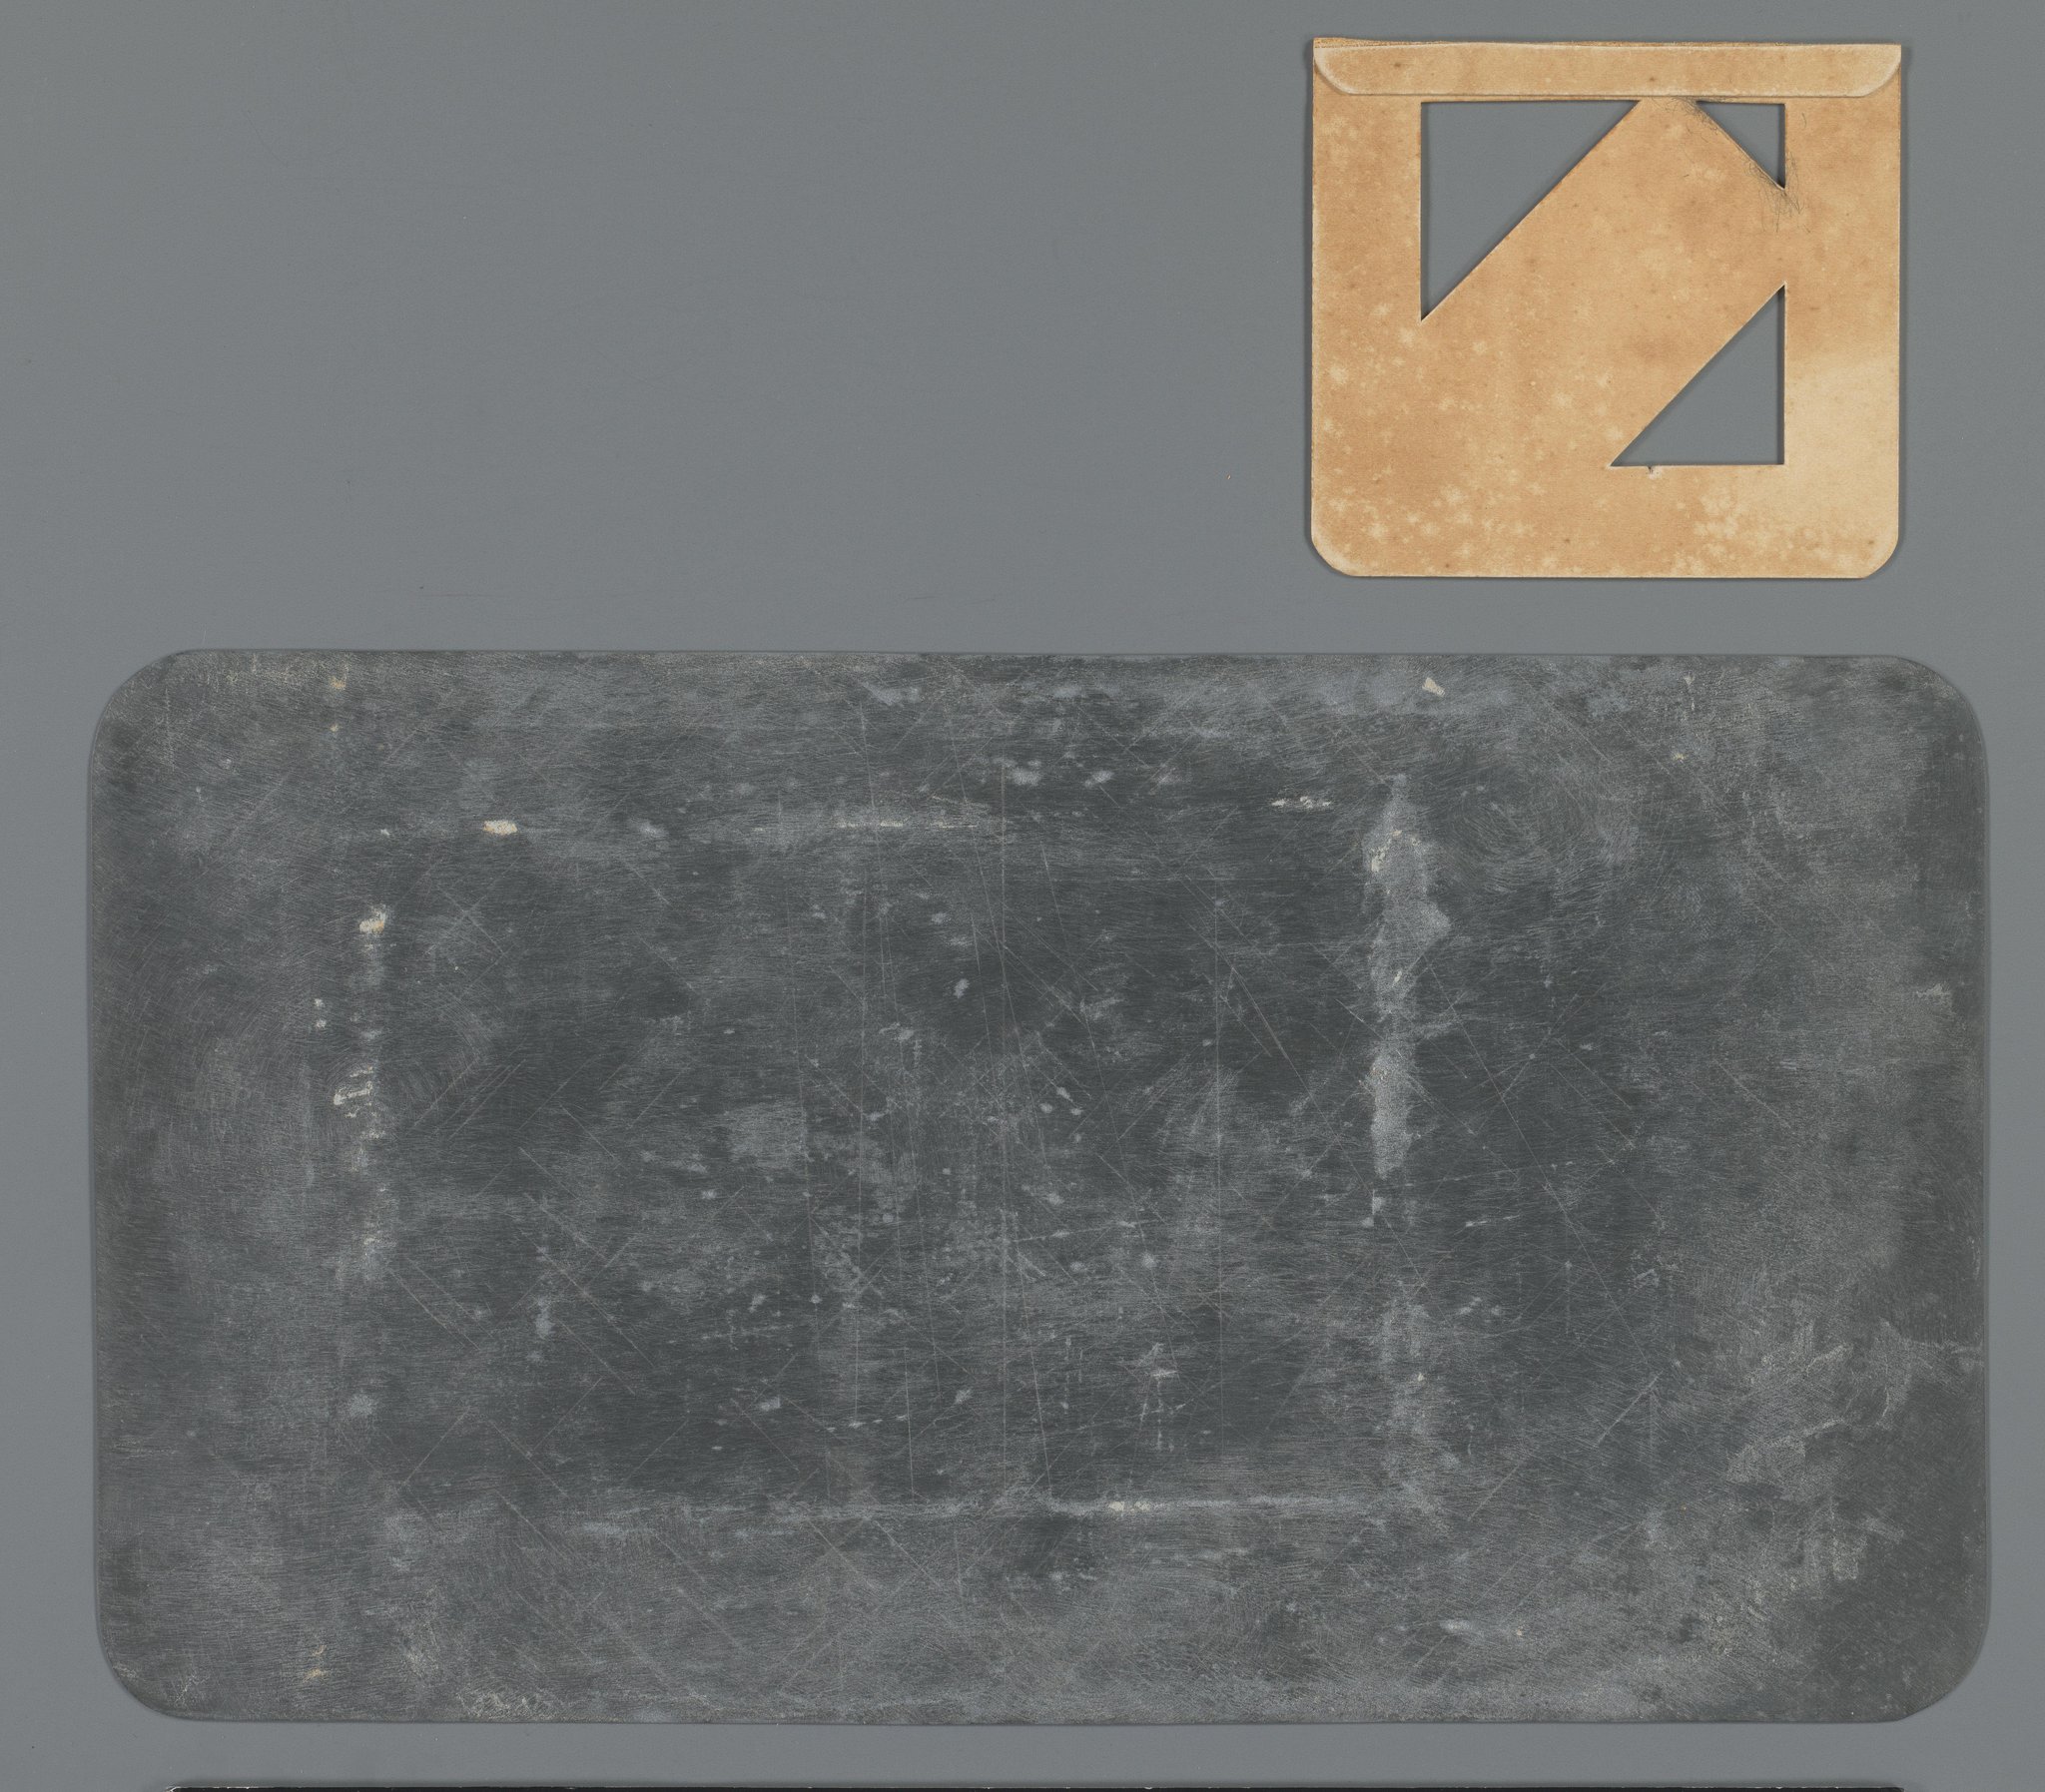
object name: cutting mat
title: Snijmat voor het snijden van papieren hoeken om foto's in te steken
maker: Anonymous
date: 1880-1950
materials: cardboard, zinc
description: Bij de snijmat zit een kartonnen vorm met uitgesneden driehoeken voor verschillende maten hoeken. De snijmat zit in een papieren verpakking.